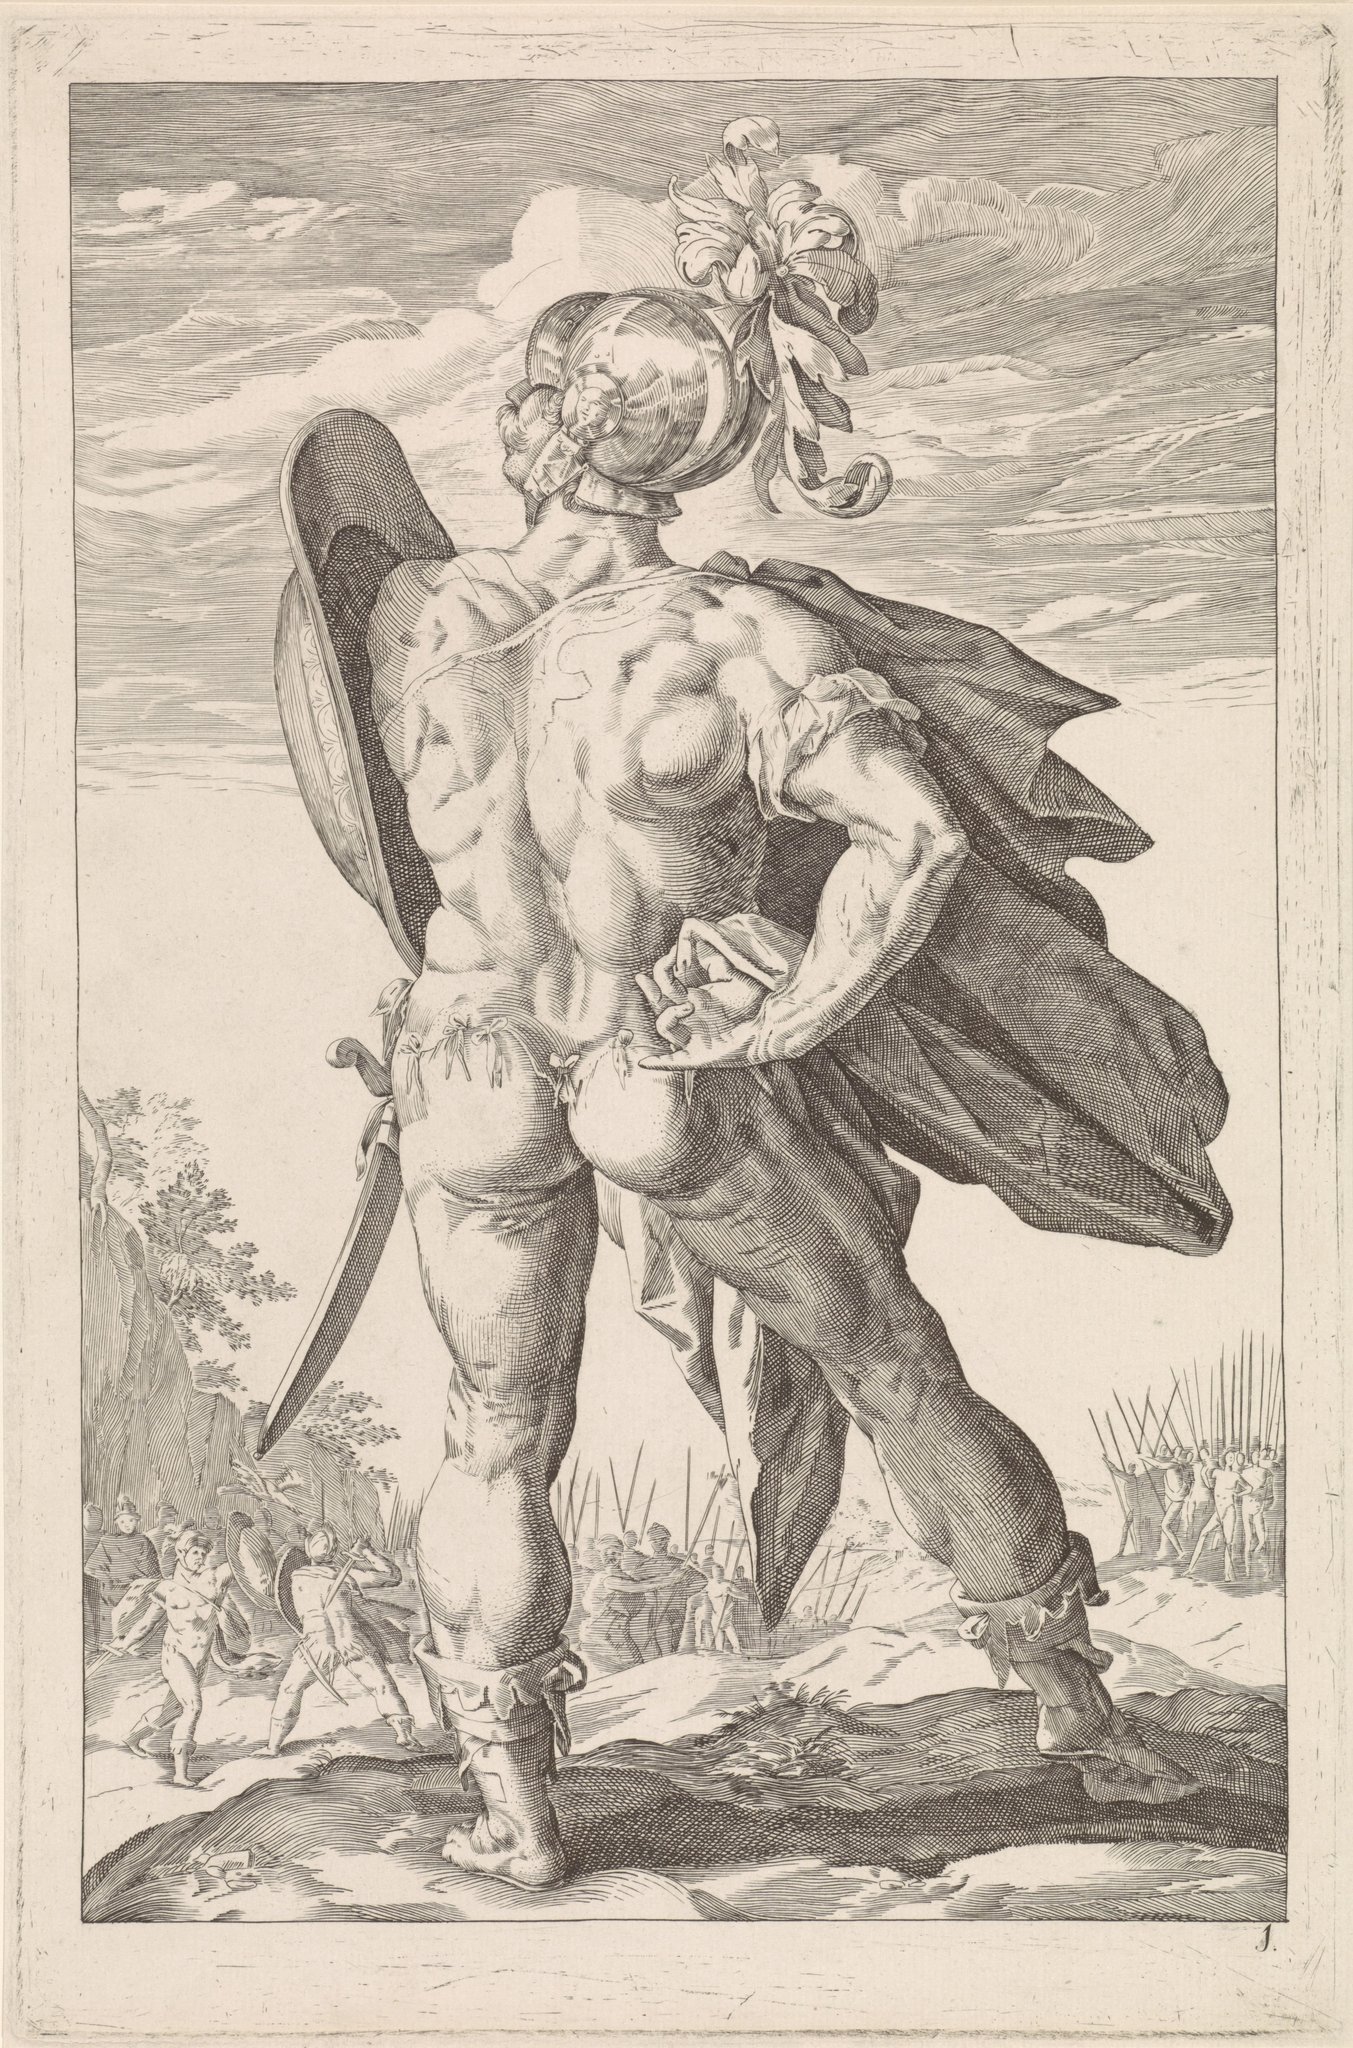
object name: print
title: Marcus Valerius Corvus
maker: keijzer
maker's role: print maker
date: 1805-1829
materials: paper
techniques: engraving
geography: amsterdam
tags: marcus valerius corvus (corvinus) victoriously fights a mighty gaul in single combat, assisted by a crow that attacks the face of the gaul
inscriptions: collector's mark: Lugt 2228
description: De held Marcus Valerius Corvus ten voeten uit, op de rug gezien, zijn schild opgeheven bij zijn linkerschouder. Op de achtergrond is te zien hoe hij met de hulp van een raaf (corvus) een Galliër verslaat.